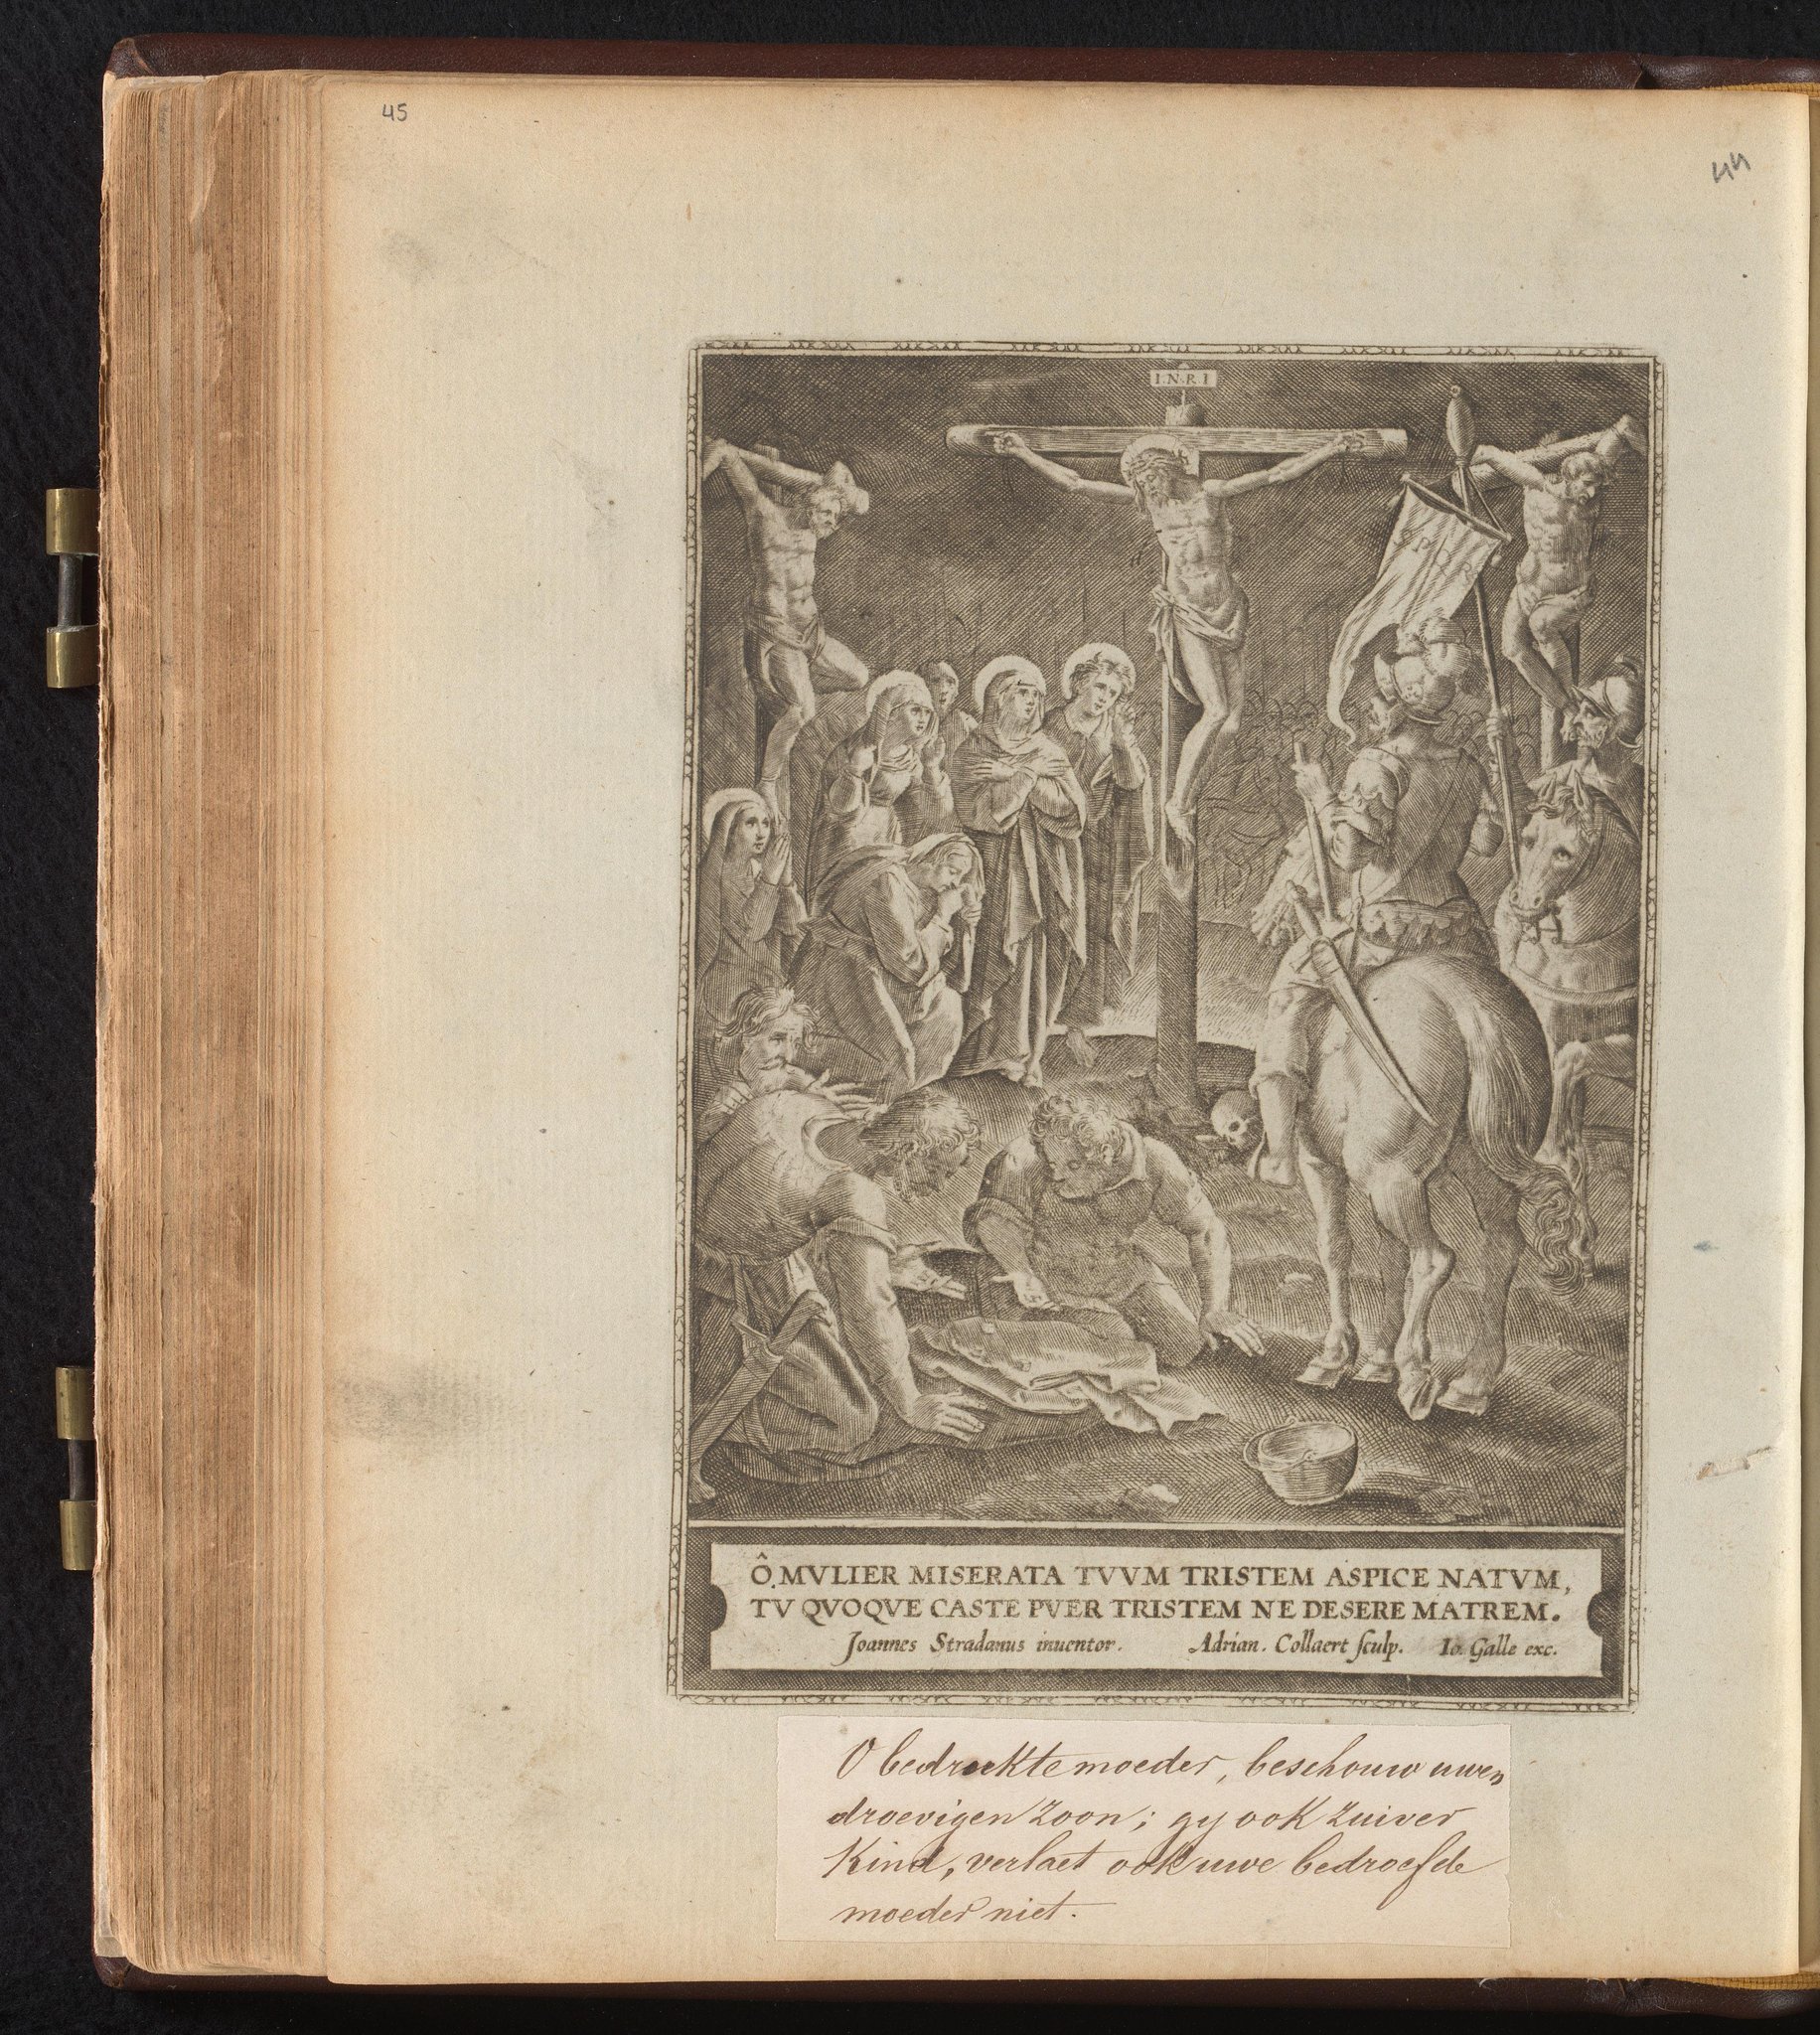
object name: album leaf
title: Christus aan het kruis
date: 1589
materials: paper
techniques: engraving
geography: antwerp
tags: the centurion confessing his belief in christ; sometimes the soldiers do the same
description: Prent maakt deel uit van een prentbijbel.